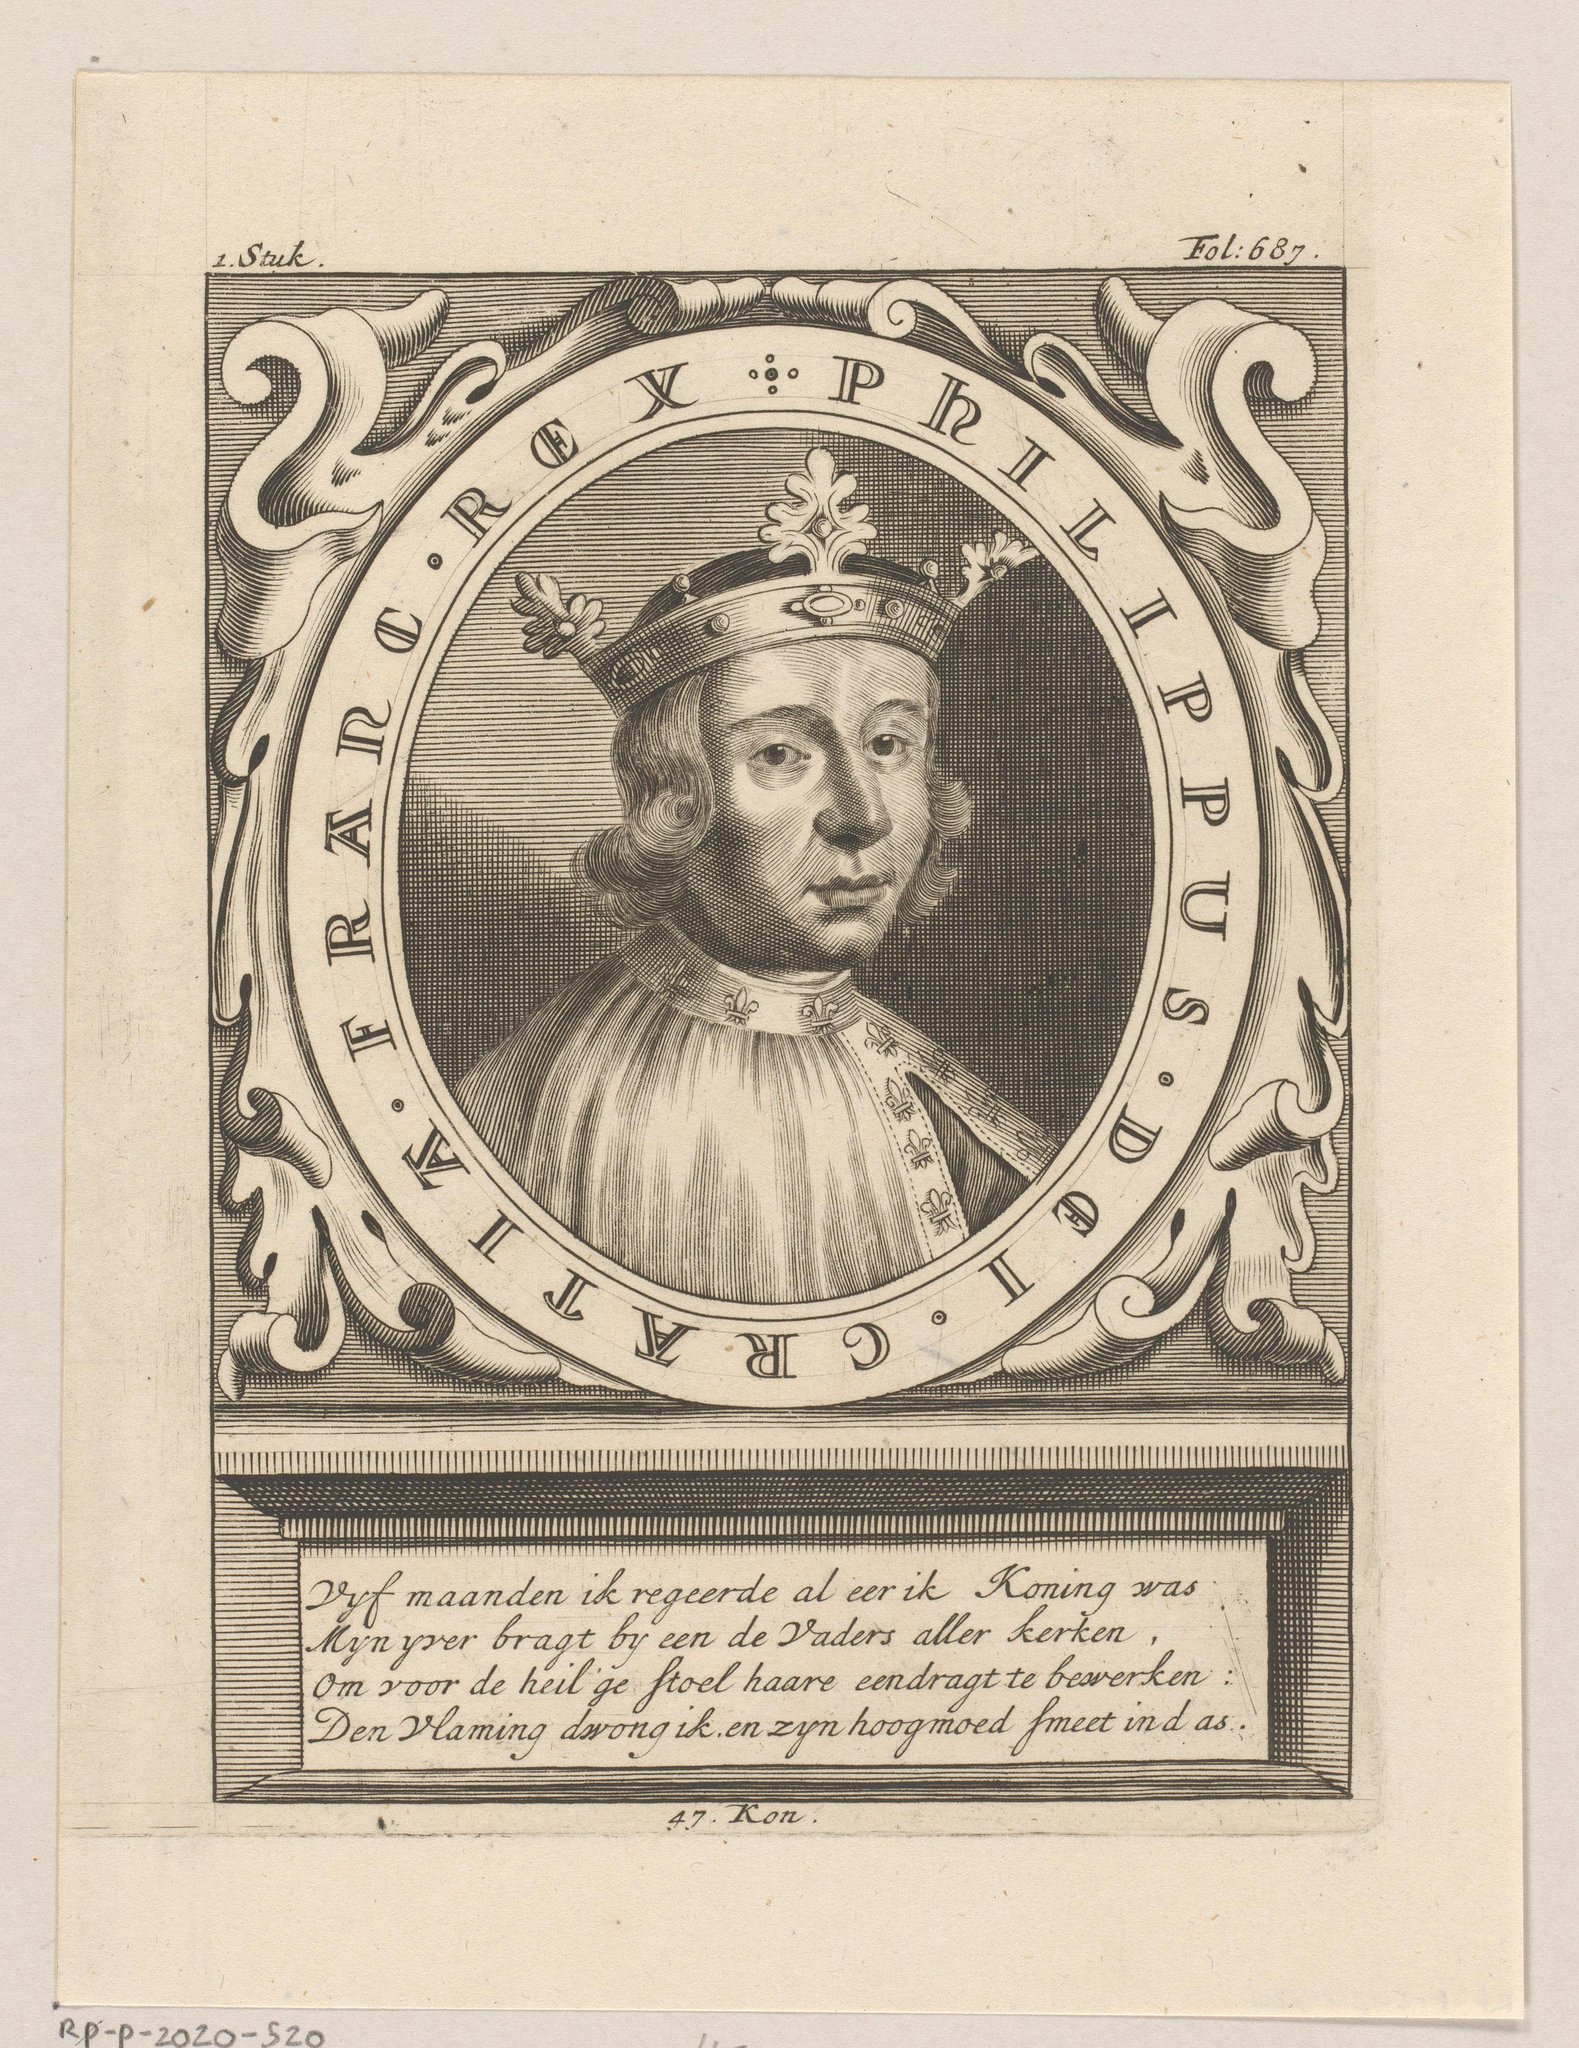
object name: book illustration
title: Philippus dei gratia Franc rex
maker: Anonymous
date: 1685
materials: paper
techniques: engraving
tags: lyon, historical persons, king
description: Prent gebruikt in: Eudes de Mézeray, François. Chronyk van Vrankryk. 6 dln. Amsterdam: Jan Bouman en Timotheum ten Hoorn, 1685, dl. 2.